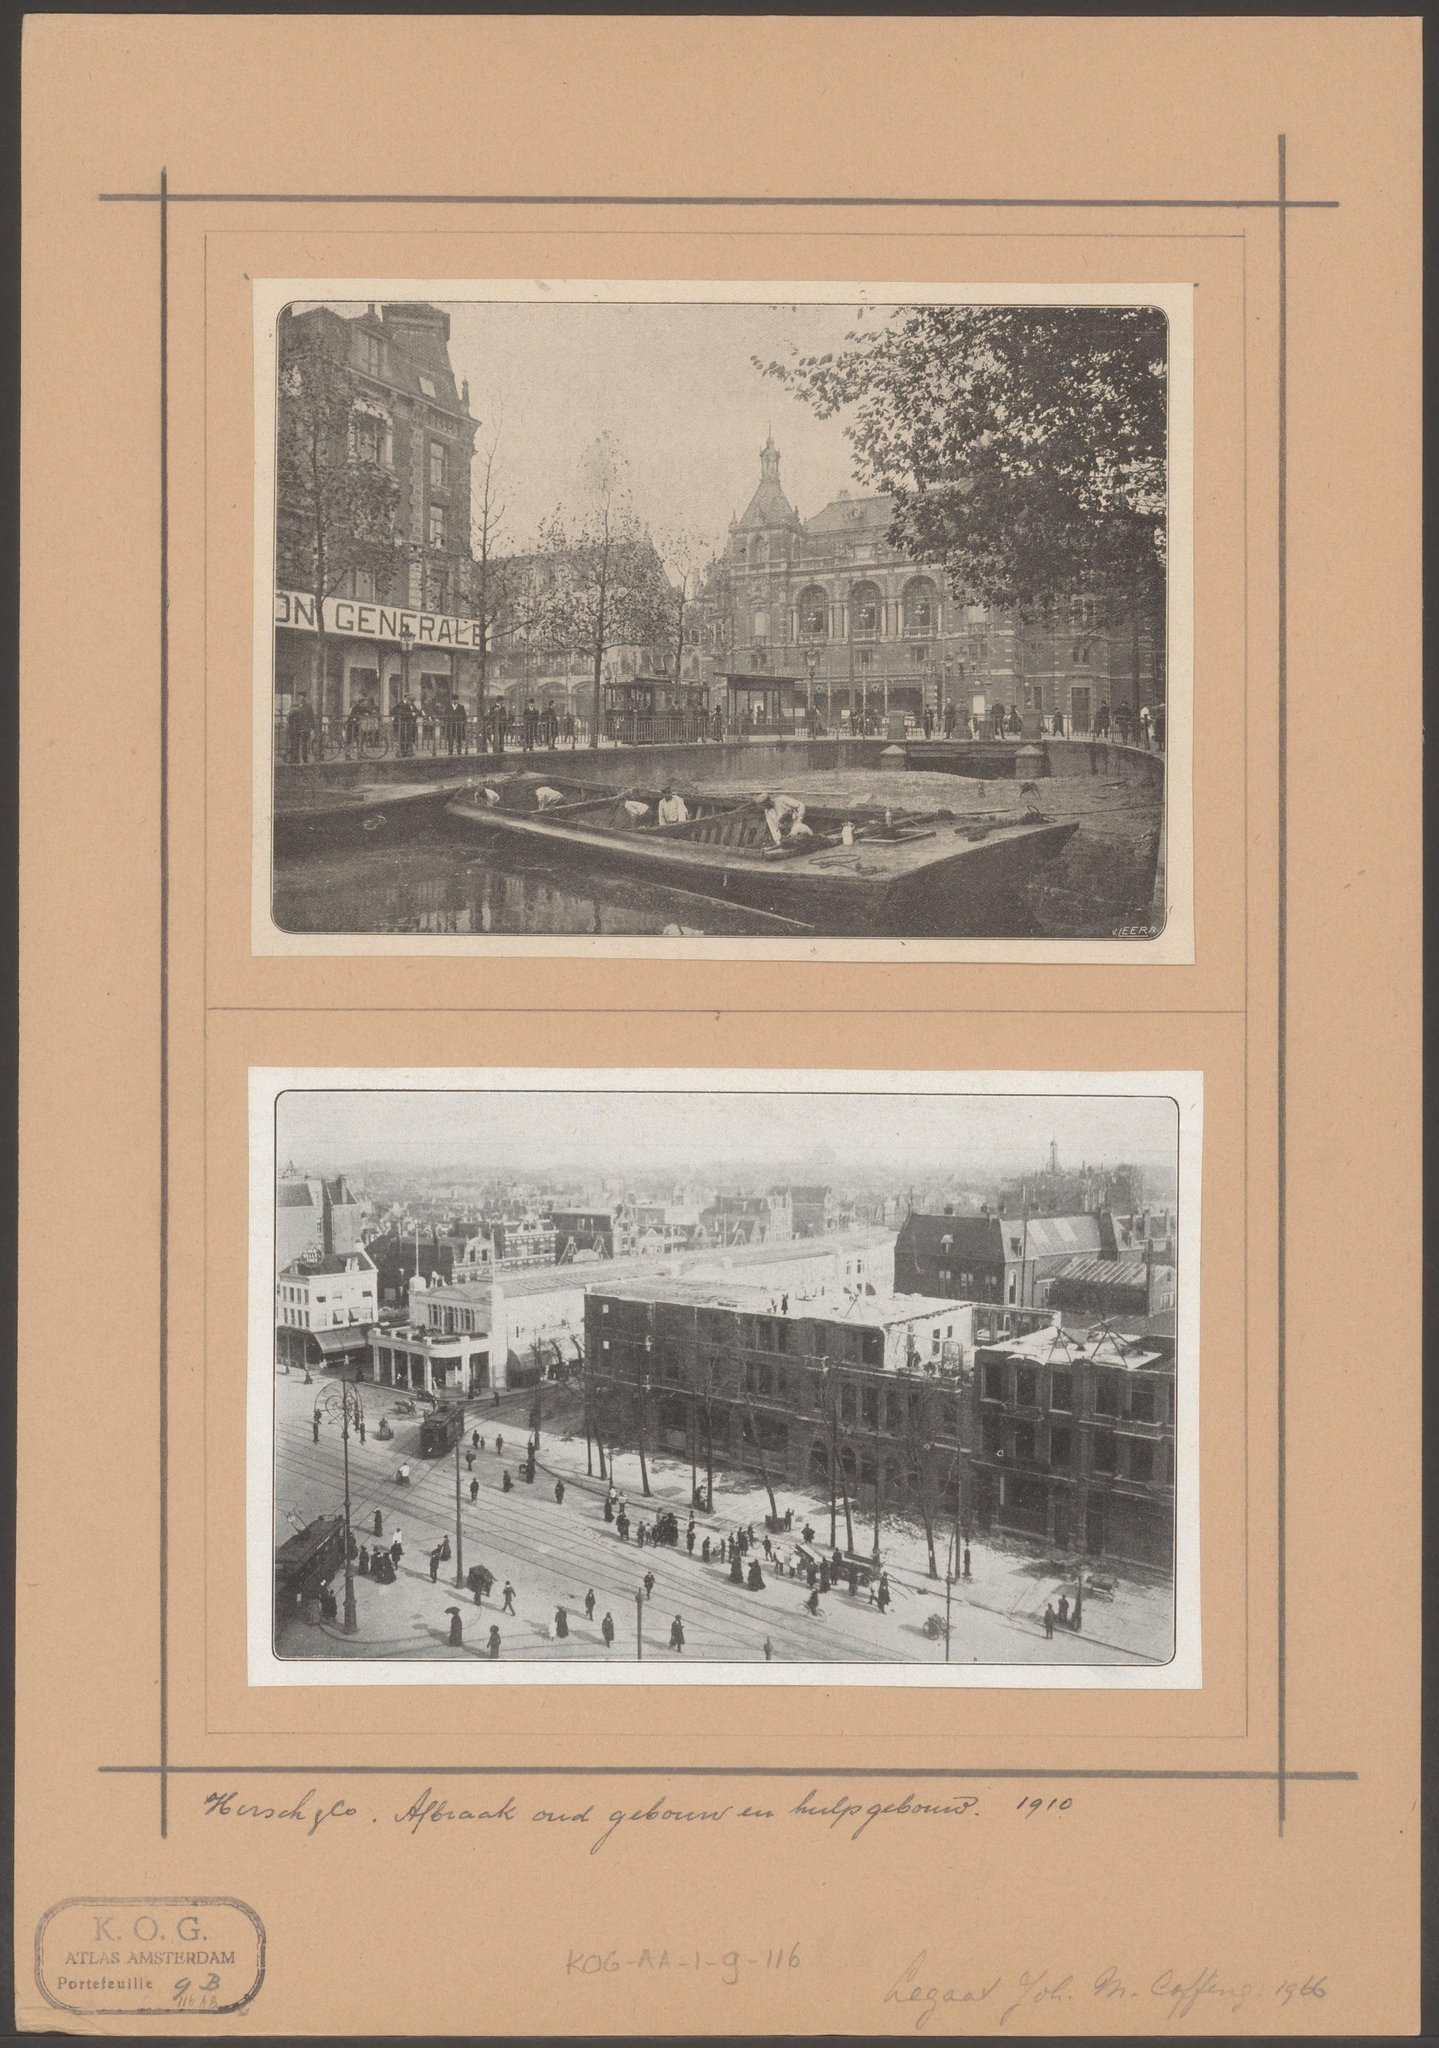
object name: photomechanical print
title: Gezichten op de afbraak van het oude gebouw van Hirsch & Cie en de noodvestiging aan het Kleine-Gartmanplantsoen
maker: Anonymous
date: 1910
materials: paper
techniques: autotype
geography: amsterdam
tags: square, place, circus, etc., tramway, tram, city-view in general; 'veduta', building-site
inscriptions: inscription: ‘Hirsch&Co. Afbraak oud gebouw en hulpgebouw. 1910. / Legaat Joh. M. Coffeng. 1966’, collector's mark: ‘9B / 116AB’ Lugt 1641b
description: Onderwerpsrubriek binnen de Atlas Amsterdam: 2e Laurierdwarsstraat (Vuile Weespad), Leidschegracht, Leidschekade, Leidscheplein, Leidschestraat, v. Lennepkade, Lijnbaansgracht, Lauriergracht, Leliedwarsstraat, Leliegracht, Lindengracht, Lombardsteeg, Looiersgracht, Looiersstraat (Nieuwe), Leidekkerssteeg.